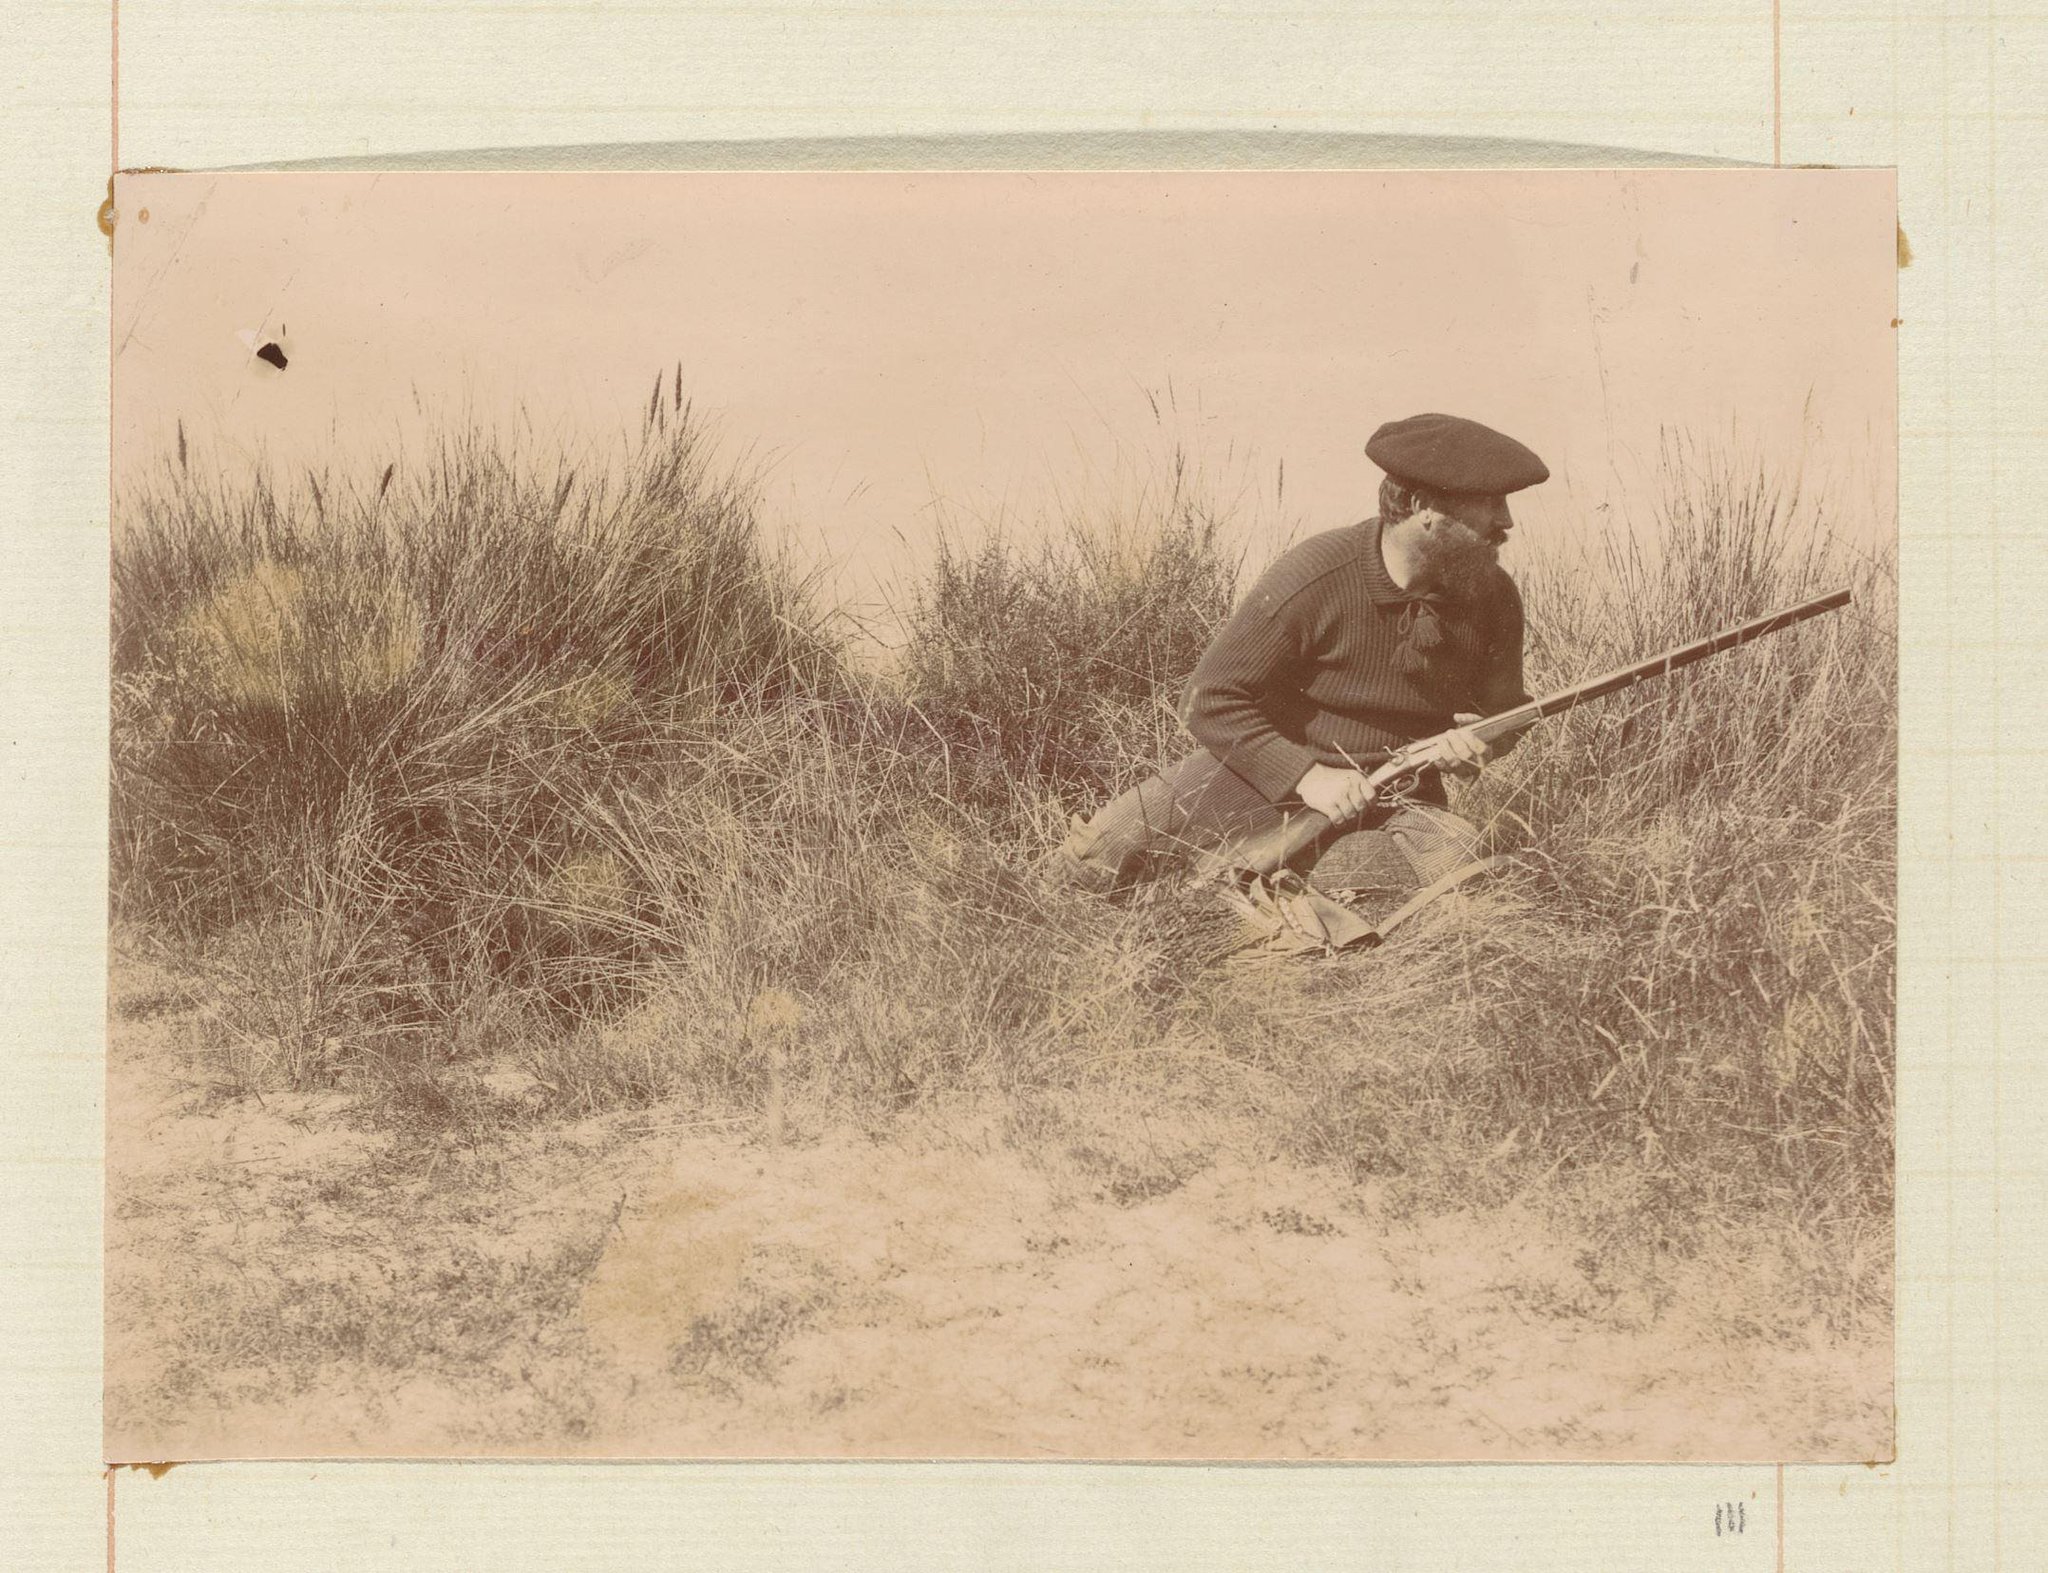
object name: photograph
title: Jager in de duinen, zittend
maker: Anonymous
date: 1880-1900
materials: paper, photographic support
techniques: gelatin silver print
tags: dune coast, hunting, chase